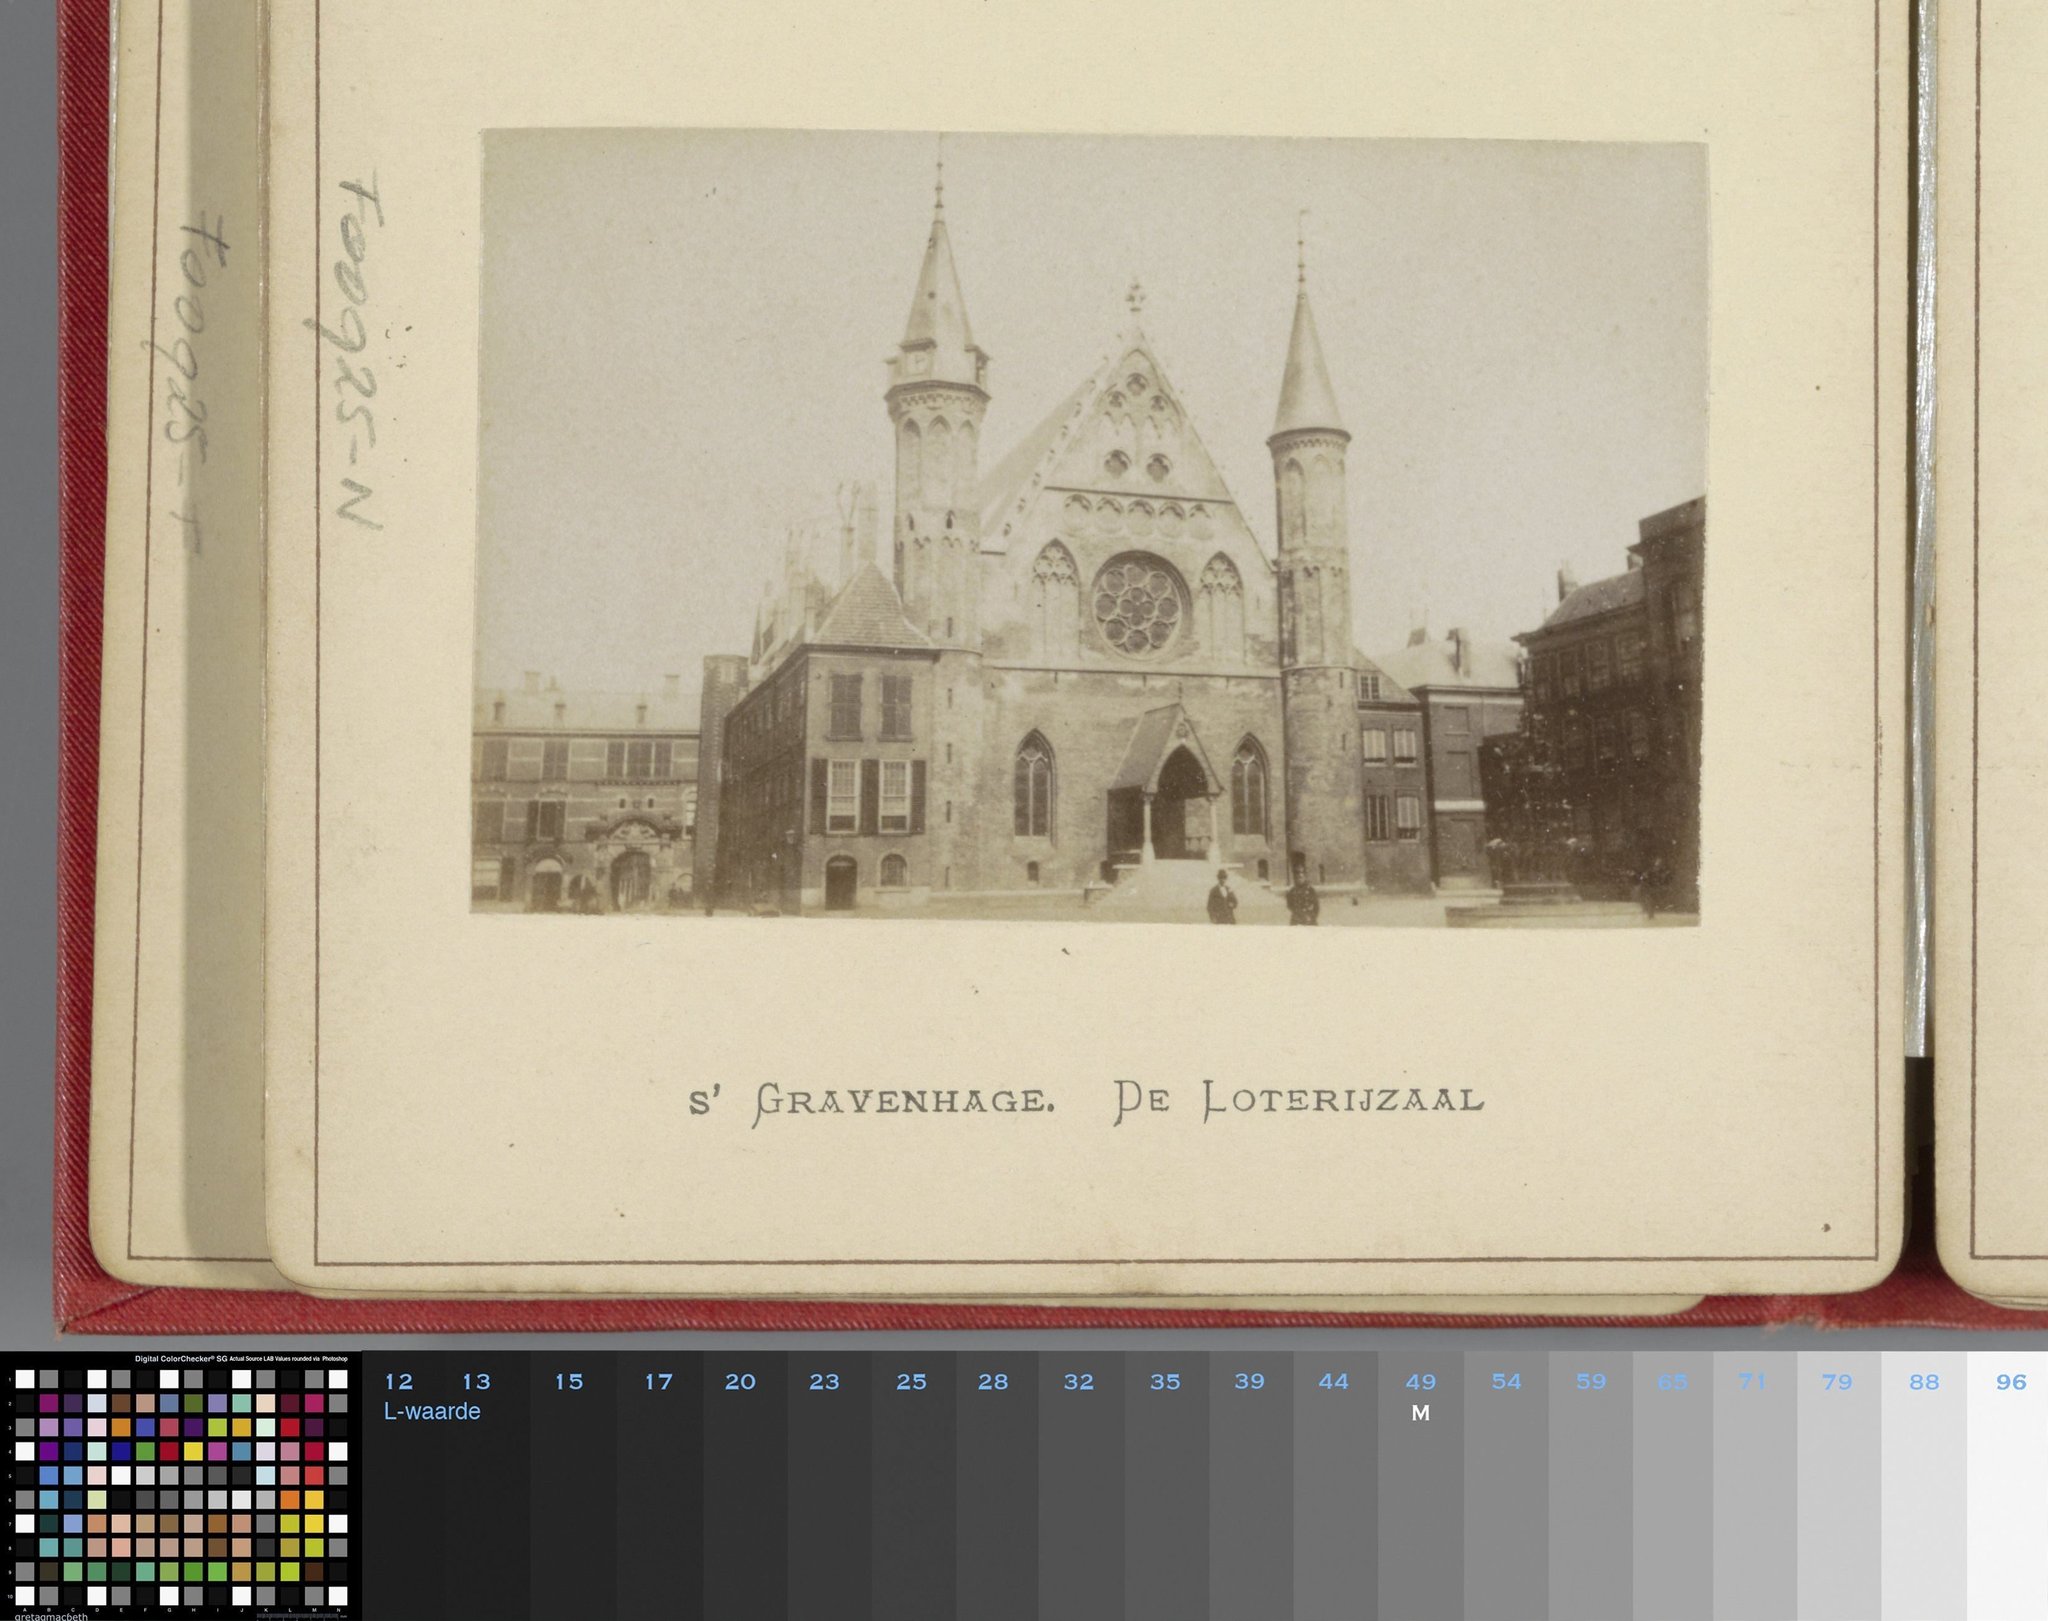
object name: album leaf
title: s' Gravenhage. De Loterijzaal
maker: andries jager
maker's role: publisher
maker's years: 1825-1905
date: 1877-1900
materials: cardboard, photographic support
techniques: albumen print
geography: the hague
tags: façade (of house or building), lower house, parliament, chamber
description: Onderdeel van Fotoalbum met opnames van steden in Noord- en Zuid-Holland en Utrecht.